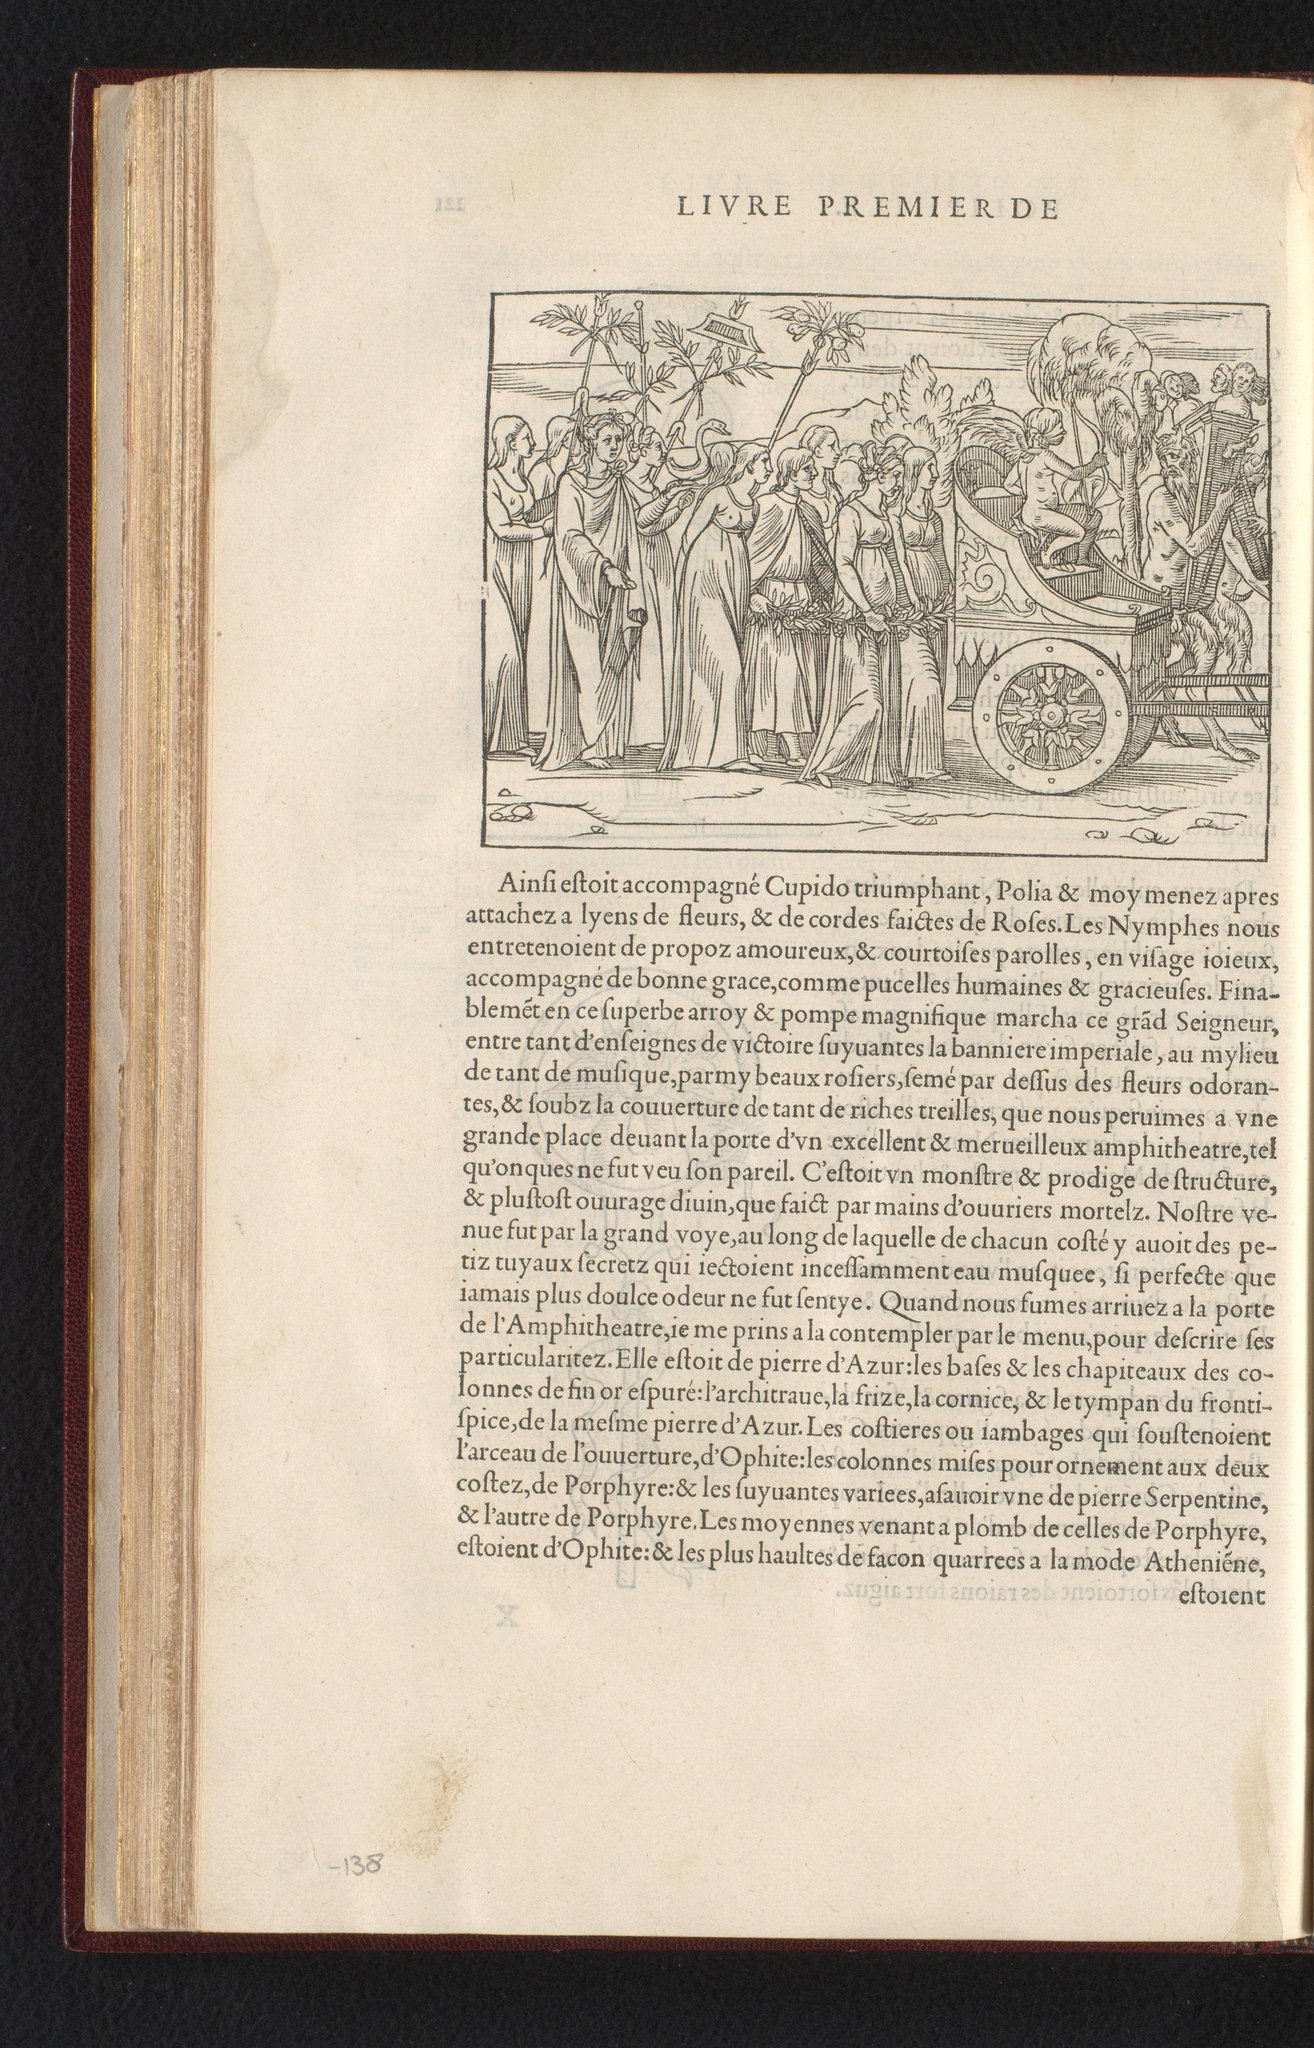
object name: page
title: Optocht met Cupido op een triomfwagen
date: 1546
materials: paper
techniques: letterpress printing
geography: paris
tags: chariot, triumphal car, (scenes from) specific works of literature: colonna, hypnerotomachia poliphili, satyr(s) (in general), (story of) cupid, amor (eros)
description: Prent uit: Colonna, Francesco. Hypnerotomachie ou discours du songe de Poliphile, deduisant comme amour le combat a l'occasion de Polia. Parijs: Jacques Kerver, 1546, verso fol. 121.